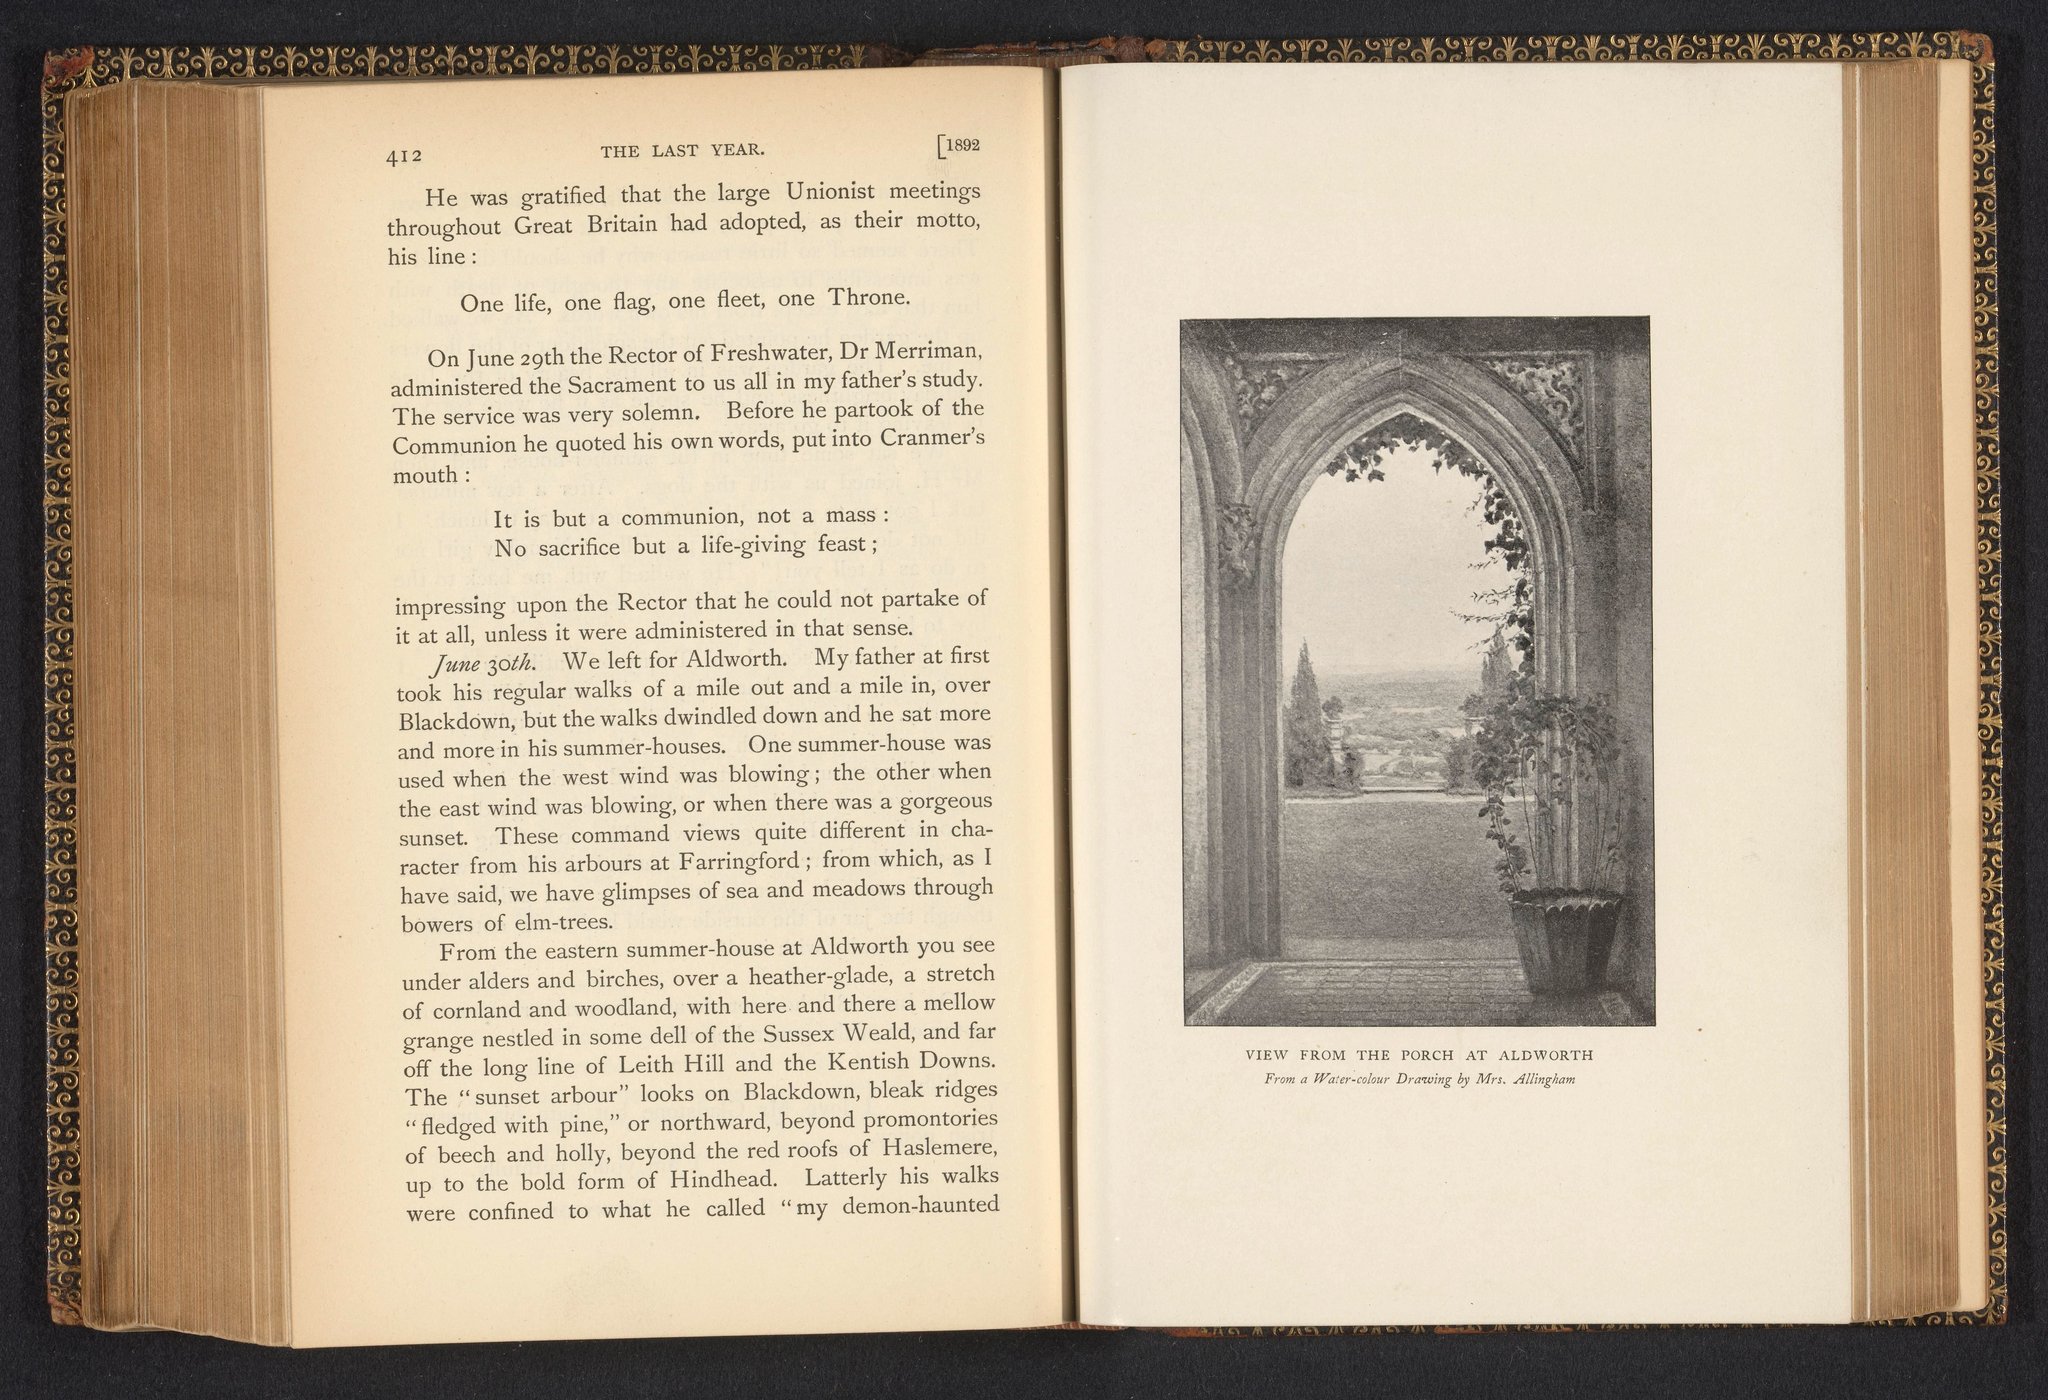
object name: page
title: View from the porch at Aldworth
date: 1887-1897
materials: paper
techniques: autotype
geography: sussex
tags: view through a window from the inside